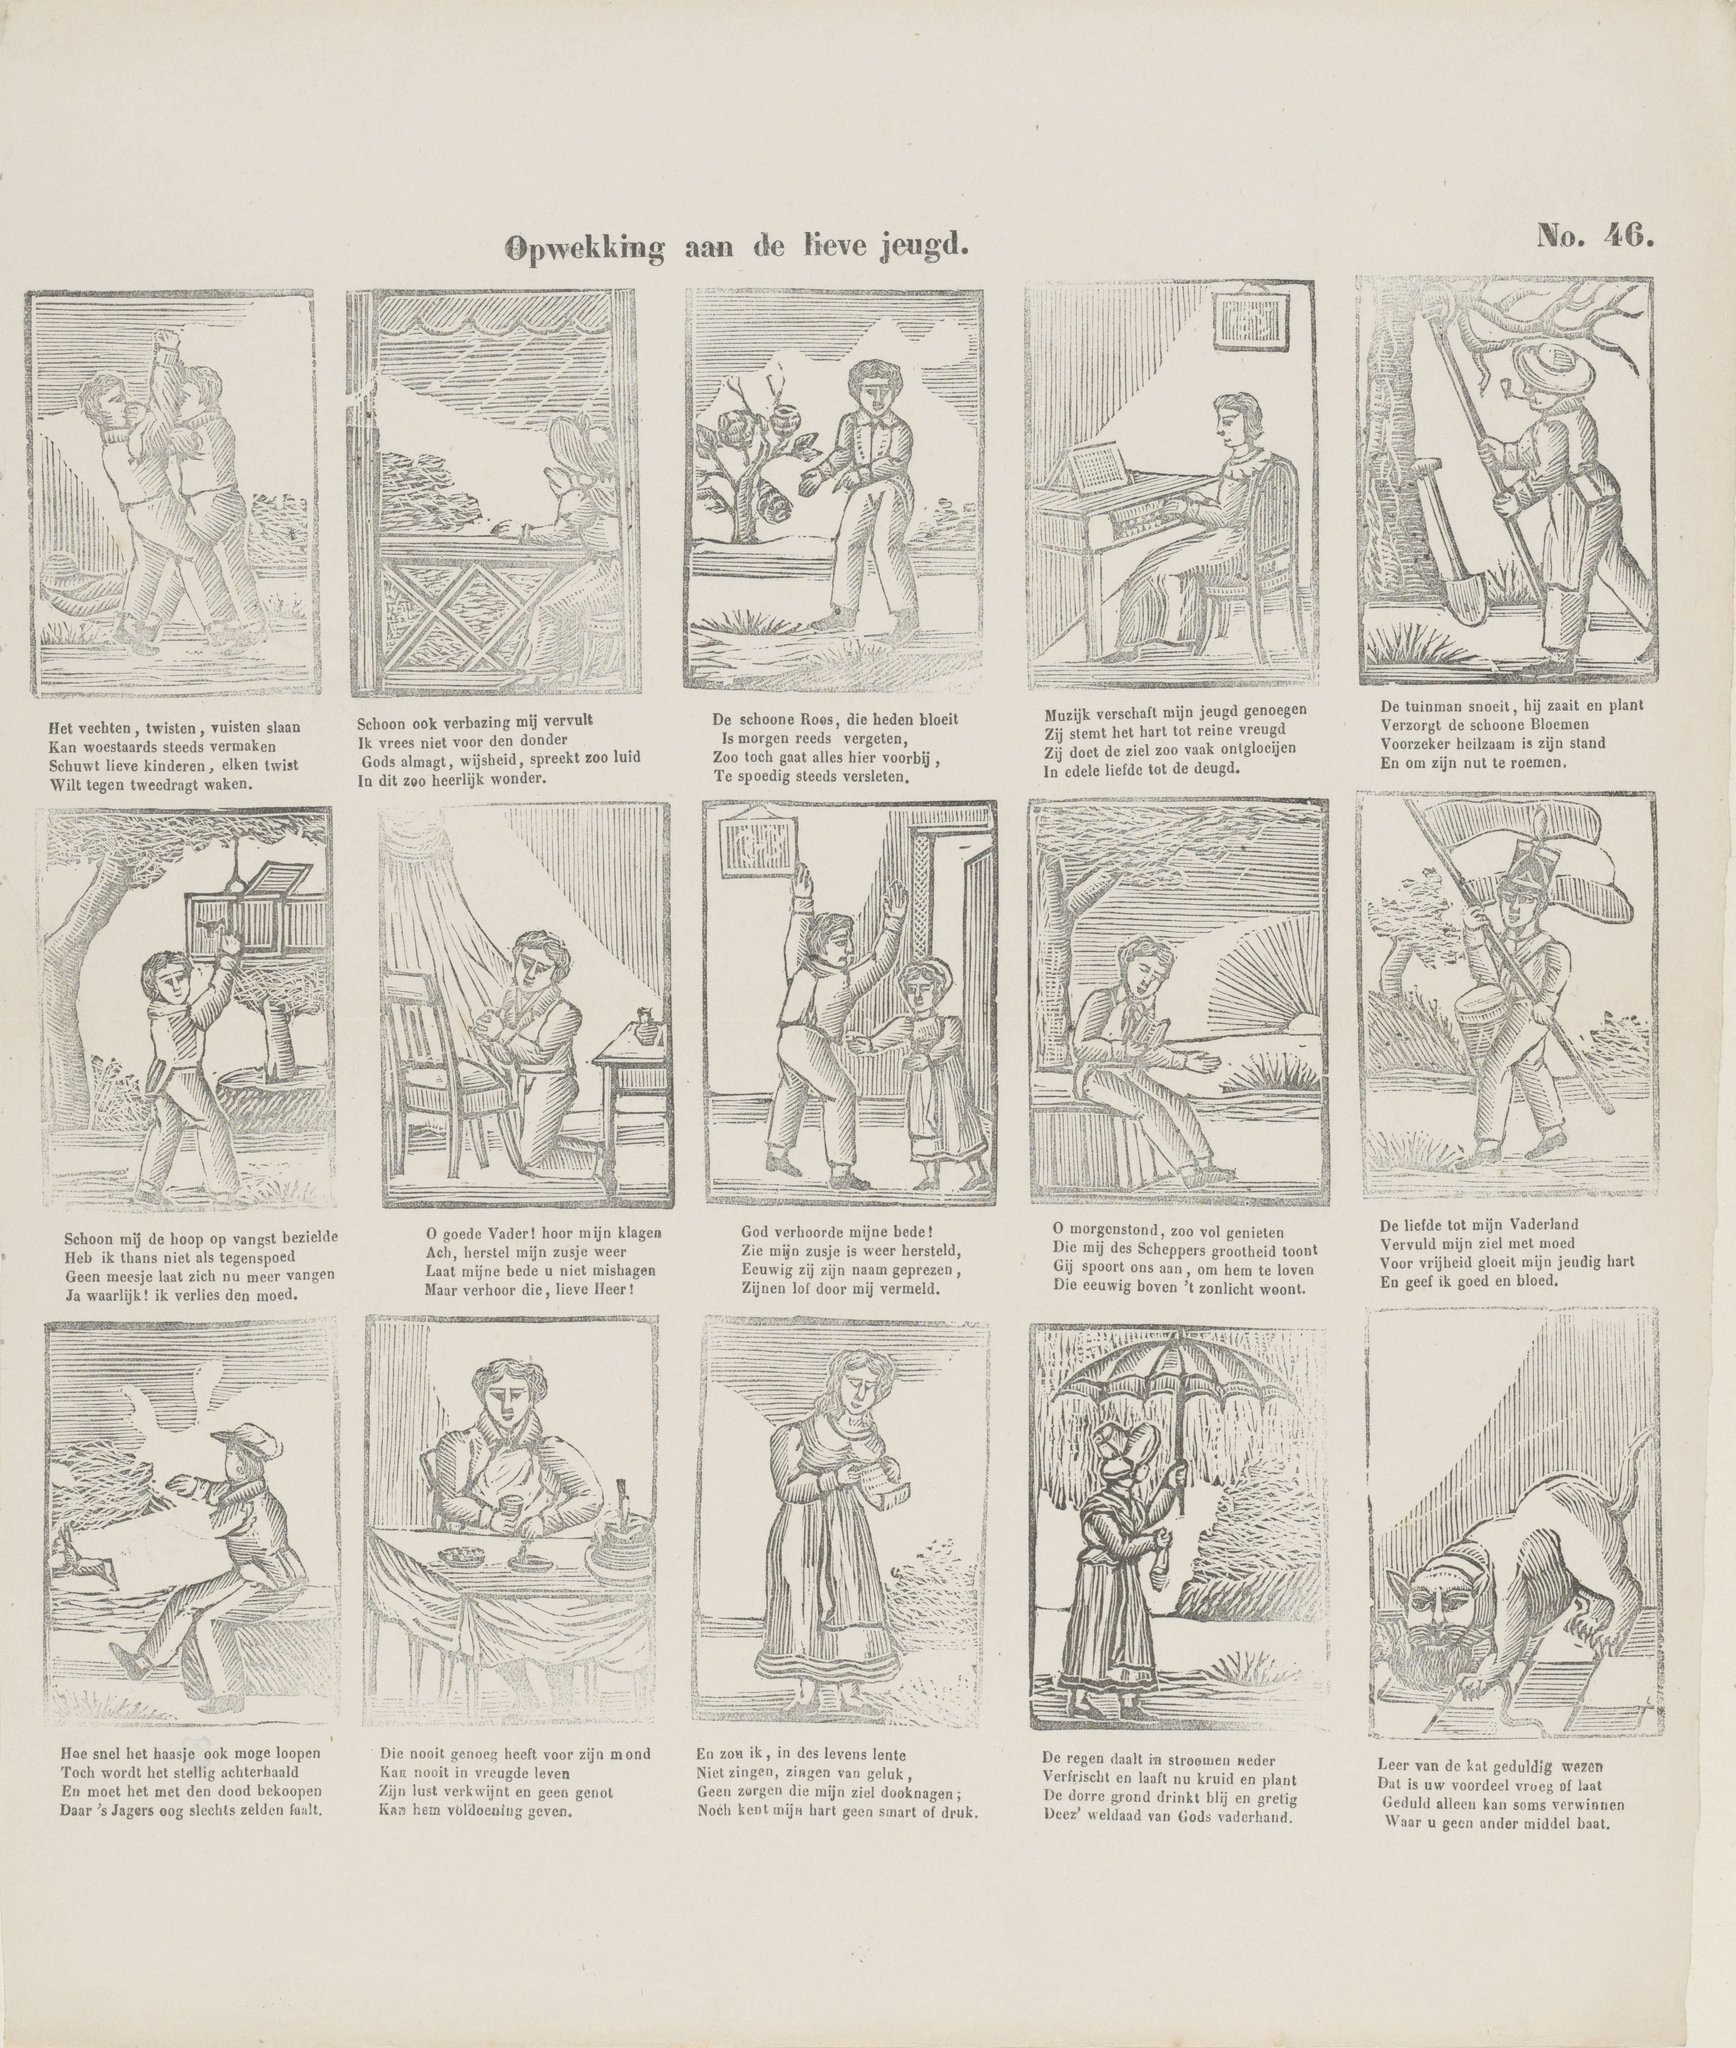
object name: popular print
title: Opwekking aan de lieve jeugd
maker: Anonymous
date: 1848-1881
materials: paper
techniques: letterpress printing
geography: den bosch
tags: bad behaviour, good behaviour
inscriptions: collector's mark: Lugt 2760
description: Blad met 15 moraliserende taferelen over goed en slecht gedrag van mensen. Onder elke afbeelding een vierregelig vers. Genummerd rechtsboven: No. 46.